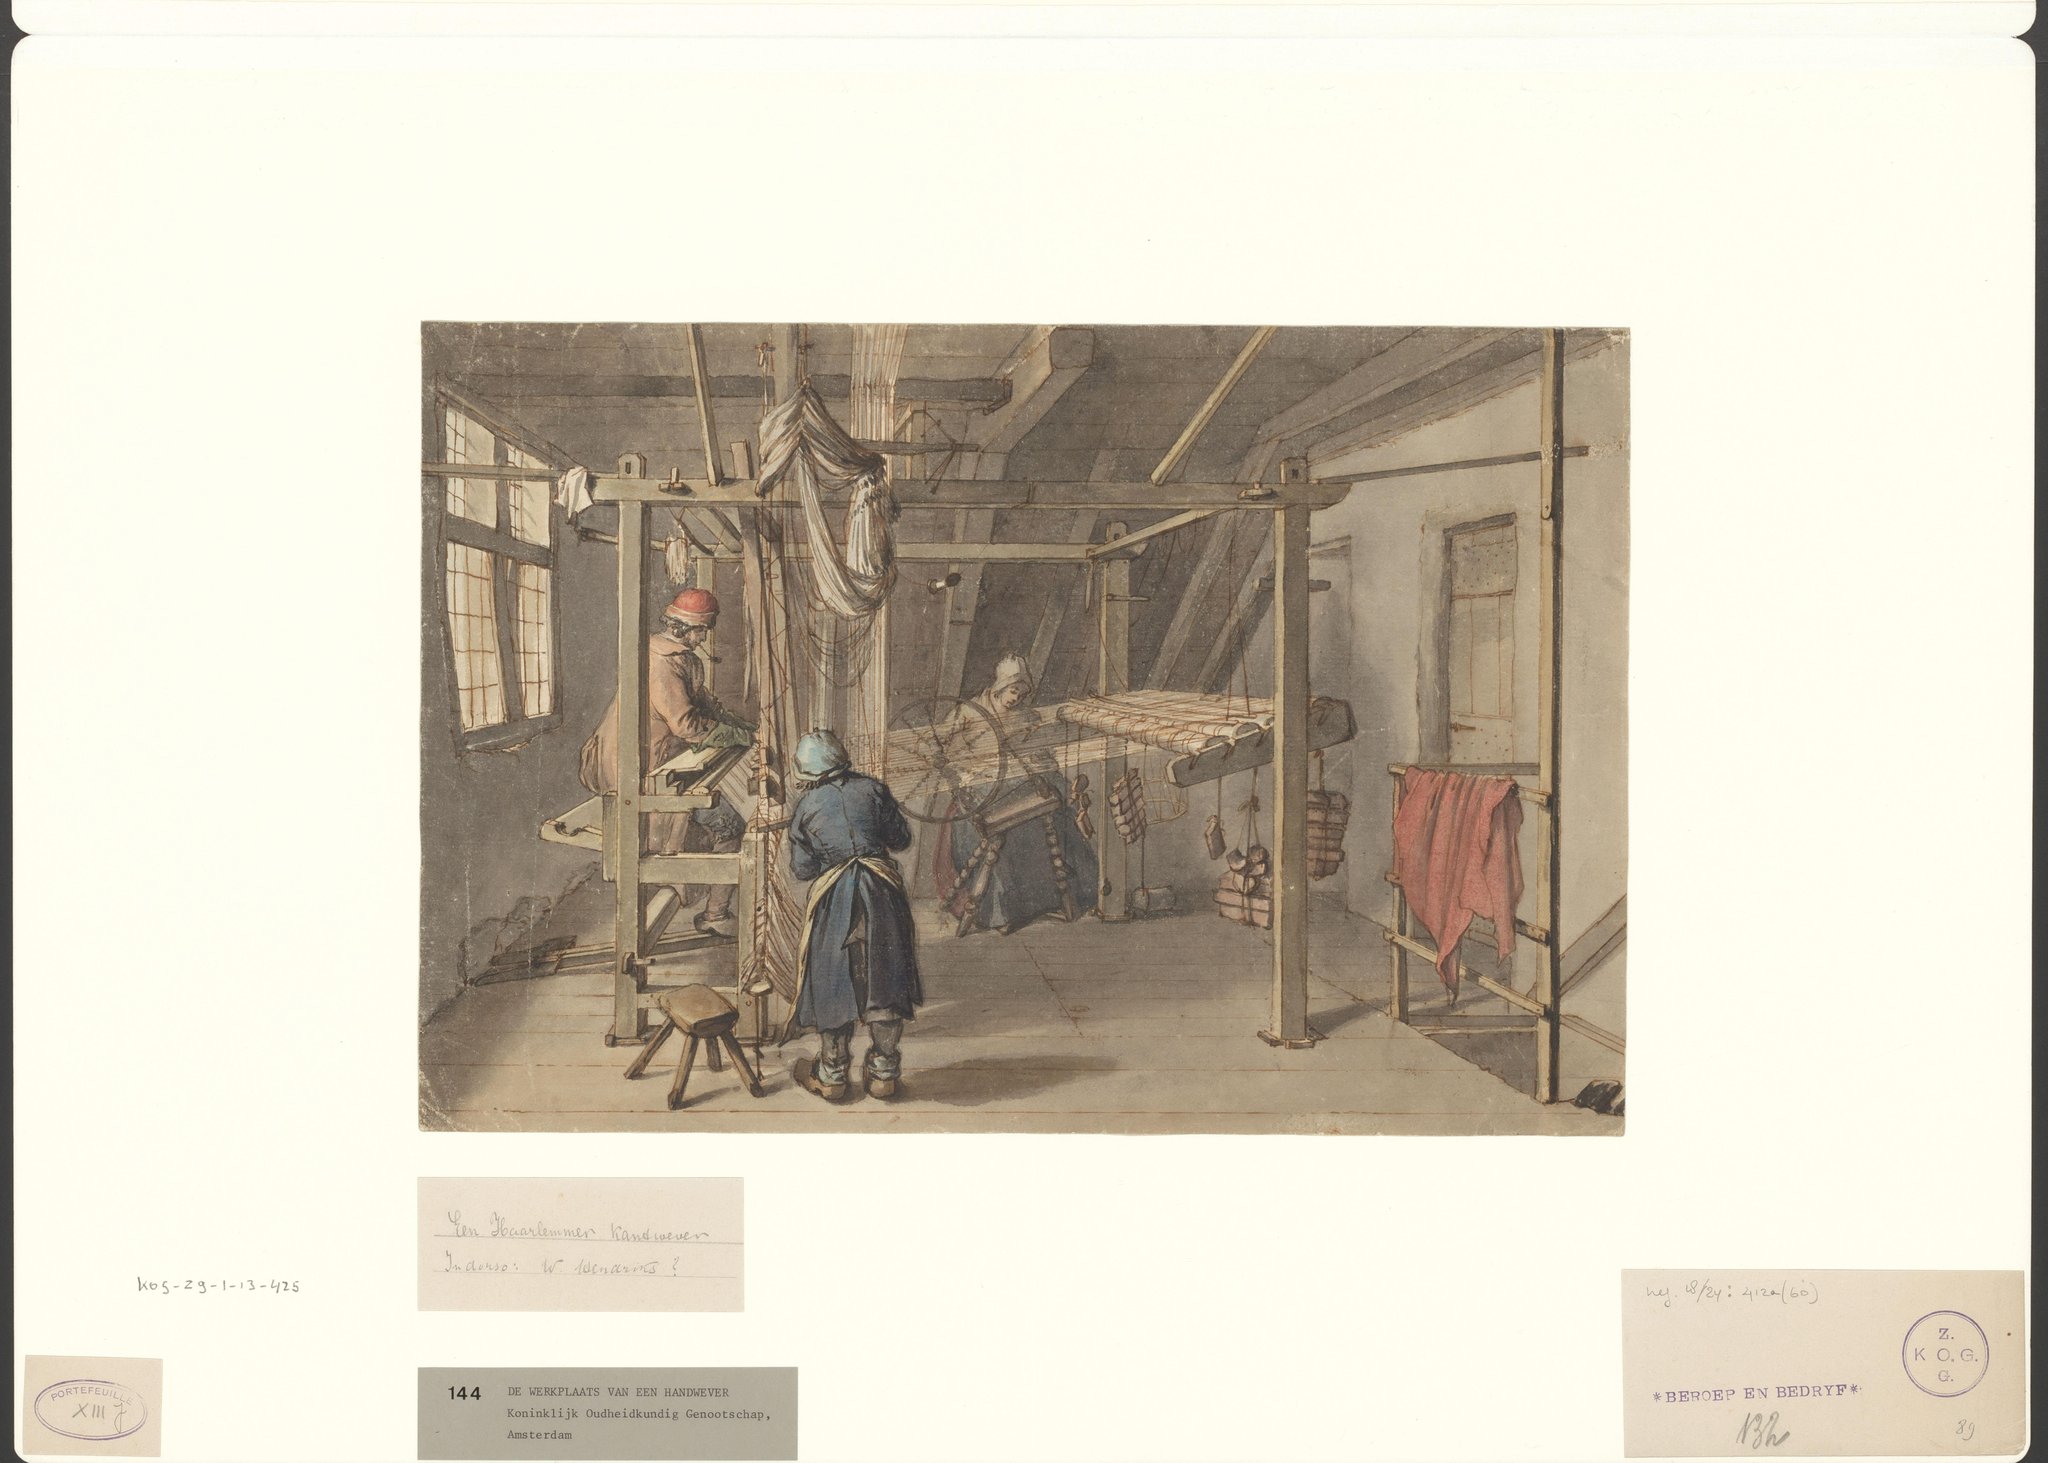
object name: drawing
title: Werkplaats van een handwerker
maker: wybrand hendriks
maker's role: draughtsman, painter, print maker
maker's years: 1744-1831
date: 1759-1831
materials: ink, paper, watercolor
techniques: brush, pen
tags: spinning-wheel, weaving, spinning (manufacture of yarn), tapestry weaver, gobelin maker, haarlem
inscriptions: collector's mark: Lugt 1641, stamp, stamp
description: Twee mensen werken met een weefgetouw. Achterin werkt een vrouw aan een spinnewiel. Onderwerpsrubrieken binnen de Atlas Zeden en Gewoonten: Handel, Nijverheid en verkeer, Beroep en bedrijf, Mannelijk, Wevers.